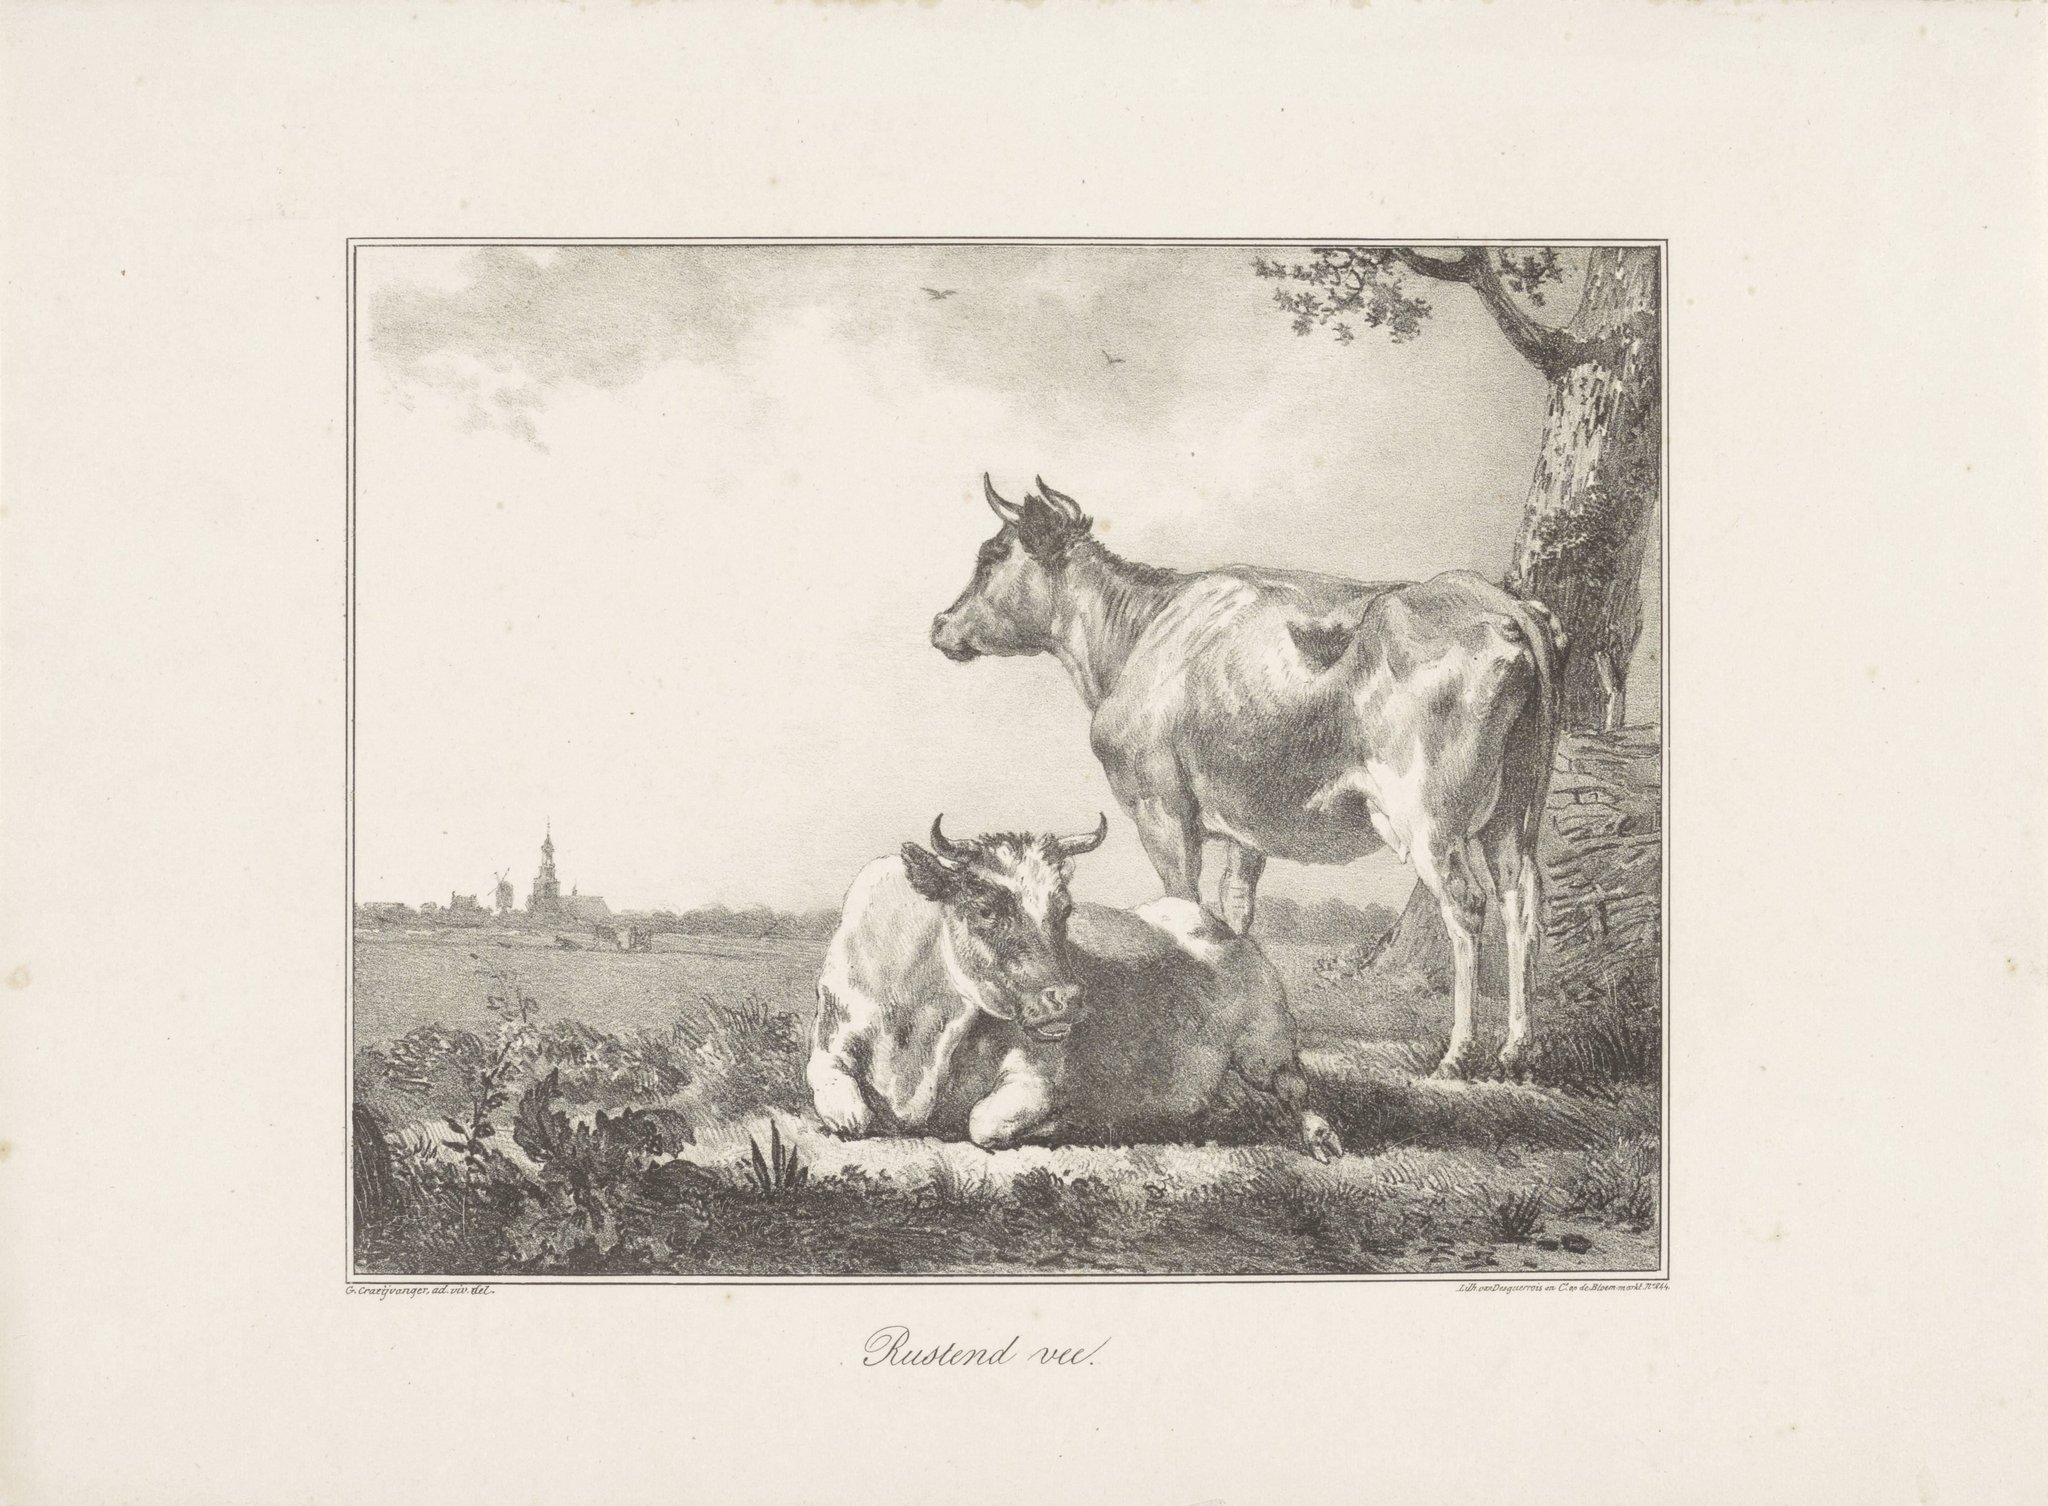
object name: print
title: Rustend vee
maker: gijsbertus craeyvanger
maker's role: draughtsman, print maker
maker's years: 1810-1895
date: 1820-1895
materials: paper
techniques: lithograph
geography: netherlands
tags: prospect of village, silhouette of village, cow, meadow, pasture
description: Waarschijnlijk maakte deze prent deel uit van de serie: 'Buitenstudien naar het leven' uitgeven in 1827 door Ambroise Jobard die werd opgevolgd door Desguerrois & Co. Zie Swillens in Jaarboek Oud Utrecht.